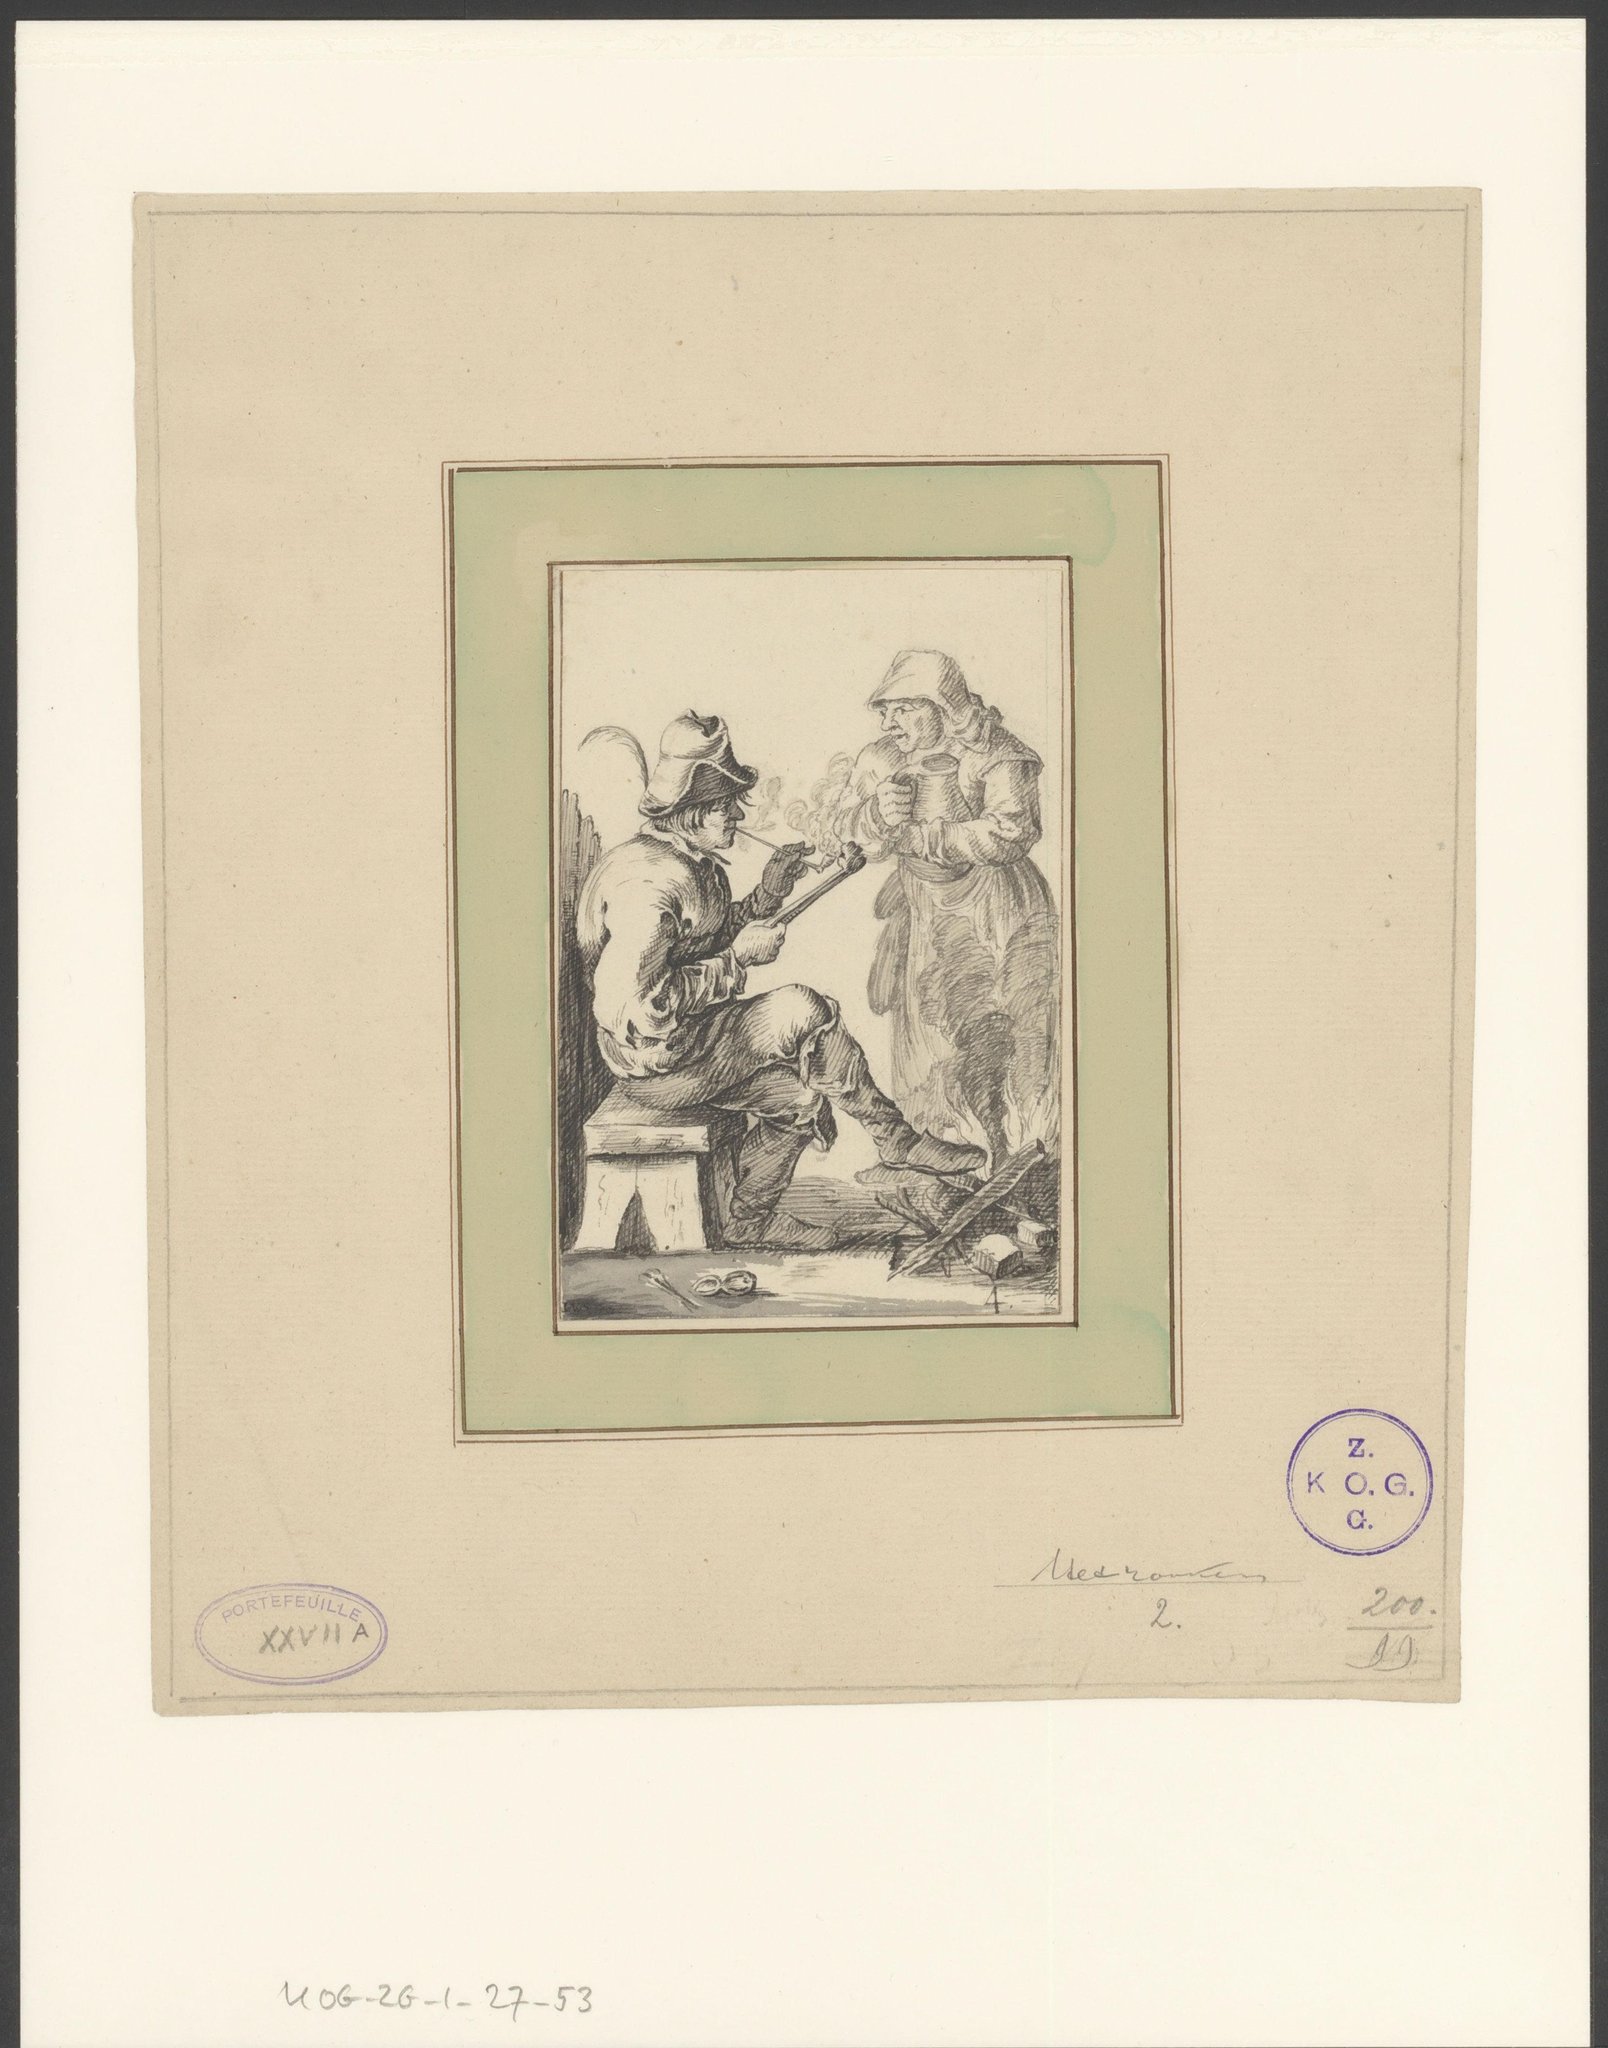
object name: drawing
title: Rokende man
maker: adalbertus engelsmet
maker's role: print maker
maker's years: 1792-1872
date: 1802-1872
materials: paper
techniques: brush, pen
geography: netherlands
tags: inn, coffee-house, public house, etc., pipe ~ tobacco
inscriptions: collector's mark: Lugt 1641, collector's mark